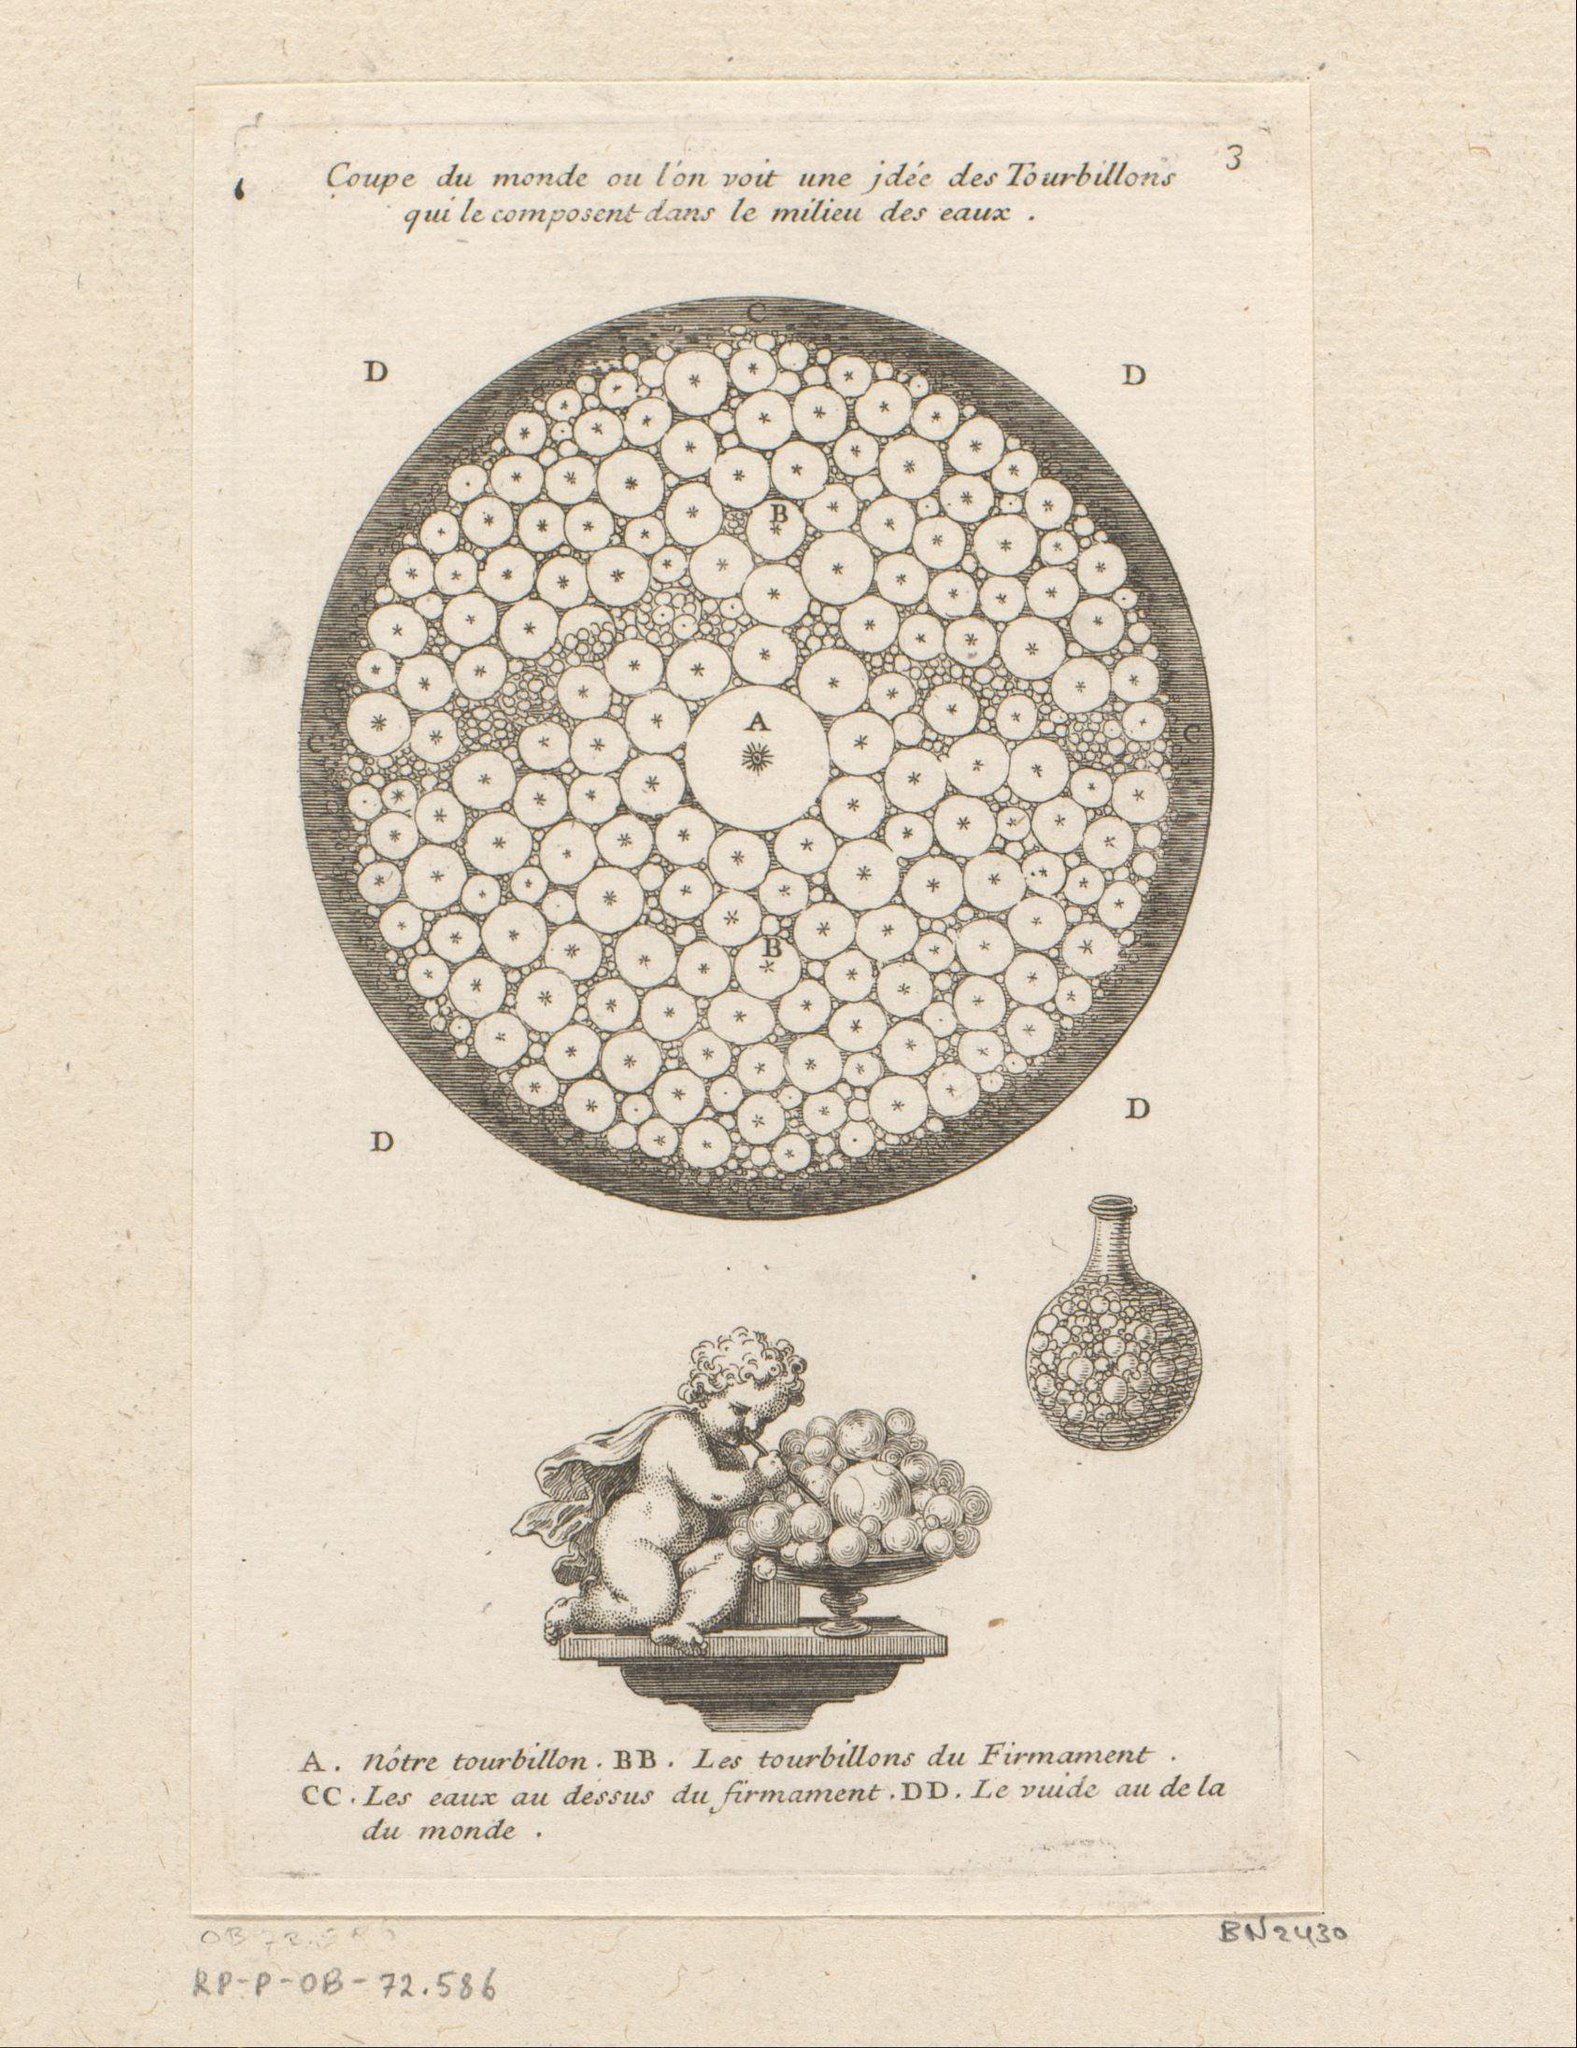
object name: print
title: Doorsnede van de Aarde met bellenblazende engel en fles met bubbels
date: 1706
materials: paper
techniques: etching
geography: paris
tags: earth, world as celestial body, (children or putti) blowing bubbles, 'homo bulla' ~ scene symbolizing 'vanitas'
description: Prent uit: Leclerc, Sébastien. Nouveau systeme du monde conforme à l'Ecriture sainte. Où les phénomènes sont expliquez sans excentricité de mouvement (...). Paris: Pierre Giffart, 1706.